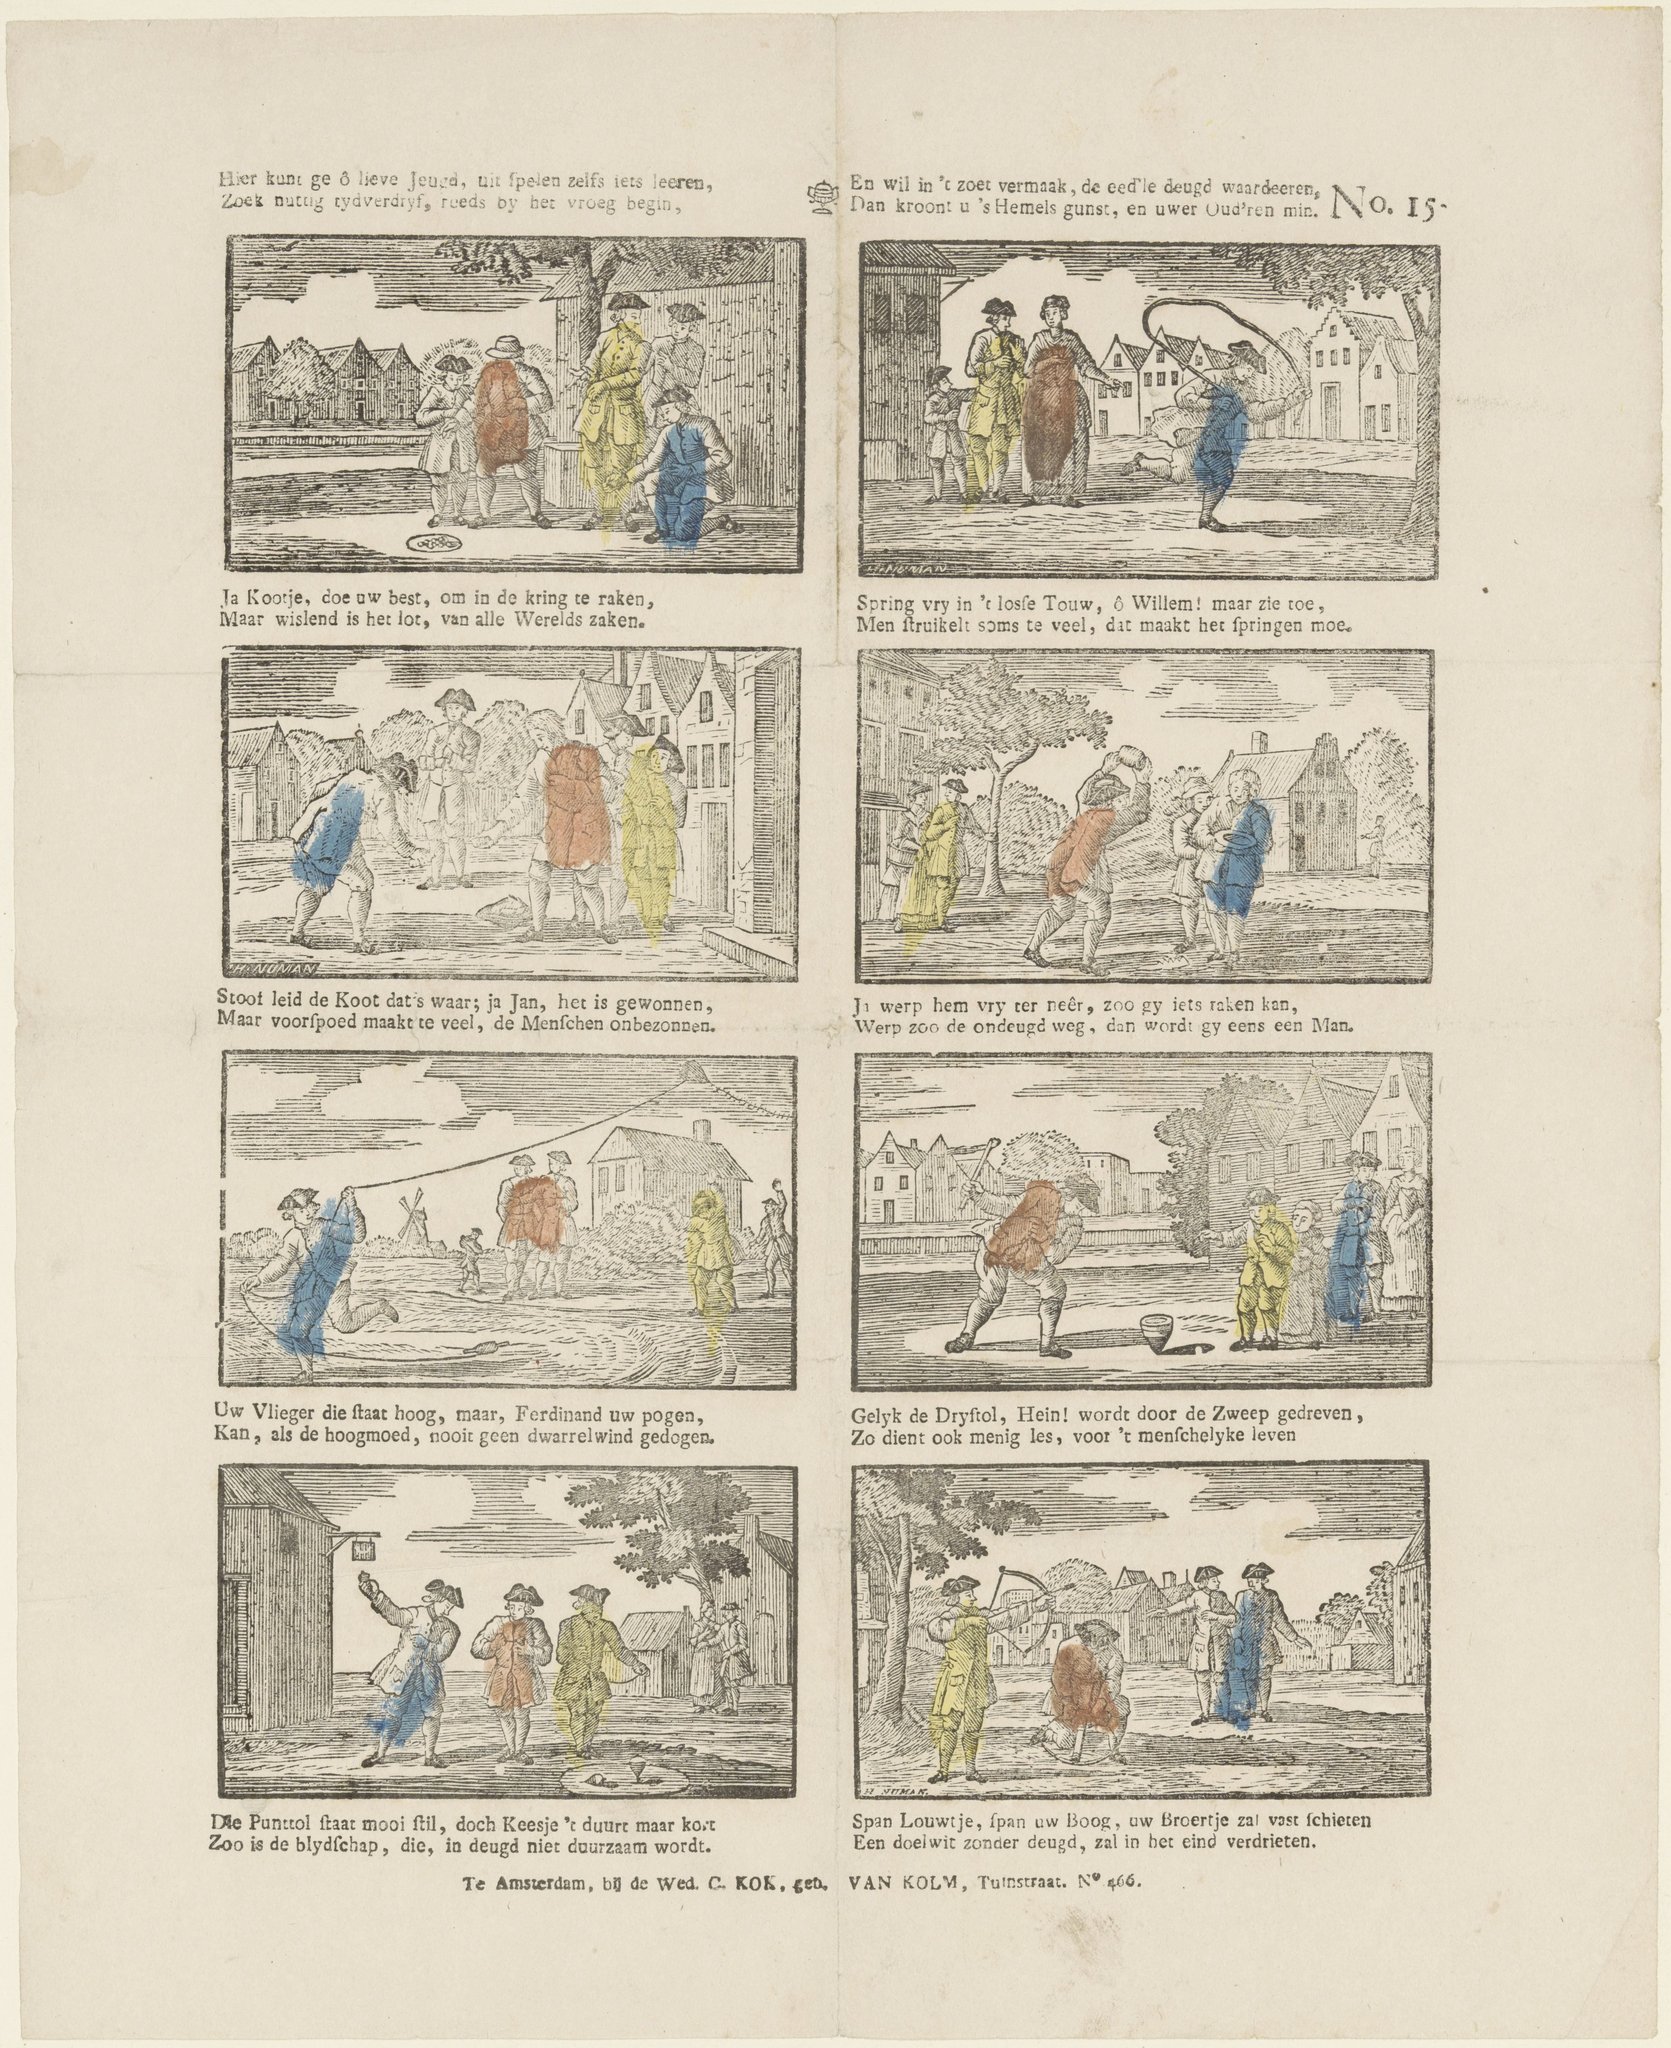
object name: popular print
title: Hier kunt ge ô lieve jeugd, uit spelen zelfs iets leeren, / zoek nuttig tydverdryf, reeds by het vroeg begin, / En wil in 't zoet vermaak, de eed'le deugd waardeeren, / Dan kroont u 's hemels gunst, en uwer oud'ren min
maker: weduwe c. kok geboren van kolm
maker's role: printer, publisher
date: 1842-1866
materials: paper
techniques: colour, letterpress printing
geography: amsterdam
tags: children's games and plays, (flying a) kite, games using special objects (marbles, top, hoop, etc.), jumping-rope games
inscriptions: collector's mark: Lugt 2760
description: Blad met 8 voorstellingen van kinderspelen, waaronder touwtjespringen, vliegeren en tollen. Onder elke afbeelding een tweeregelig vers. Genummerd rechtsboven: No. 15.